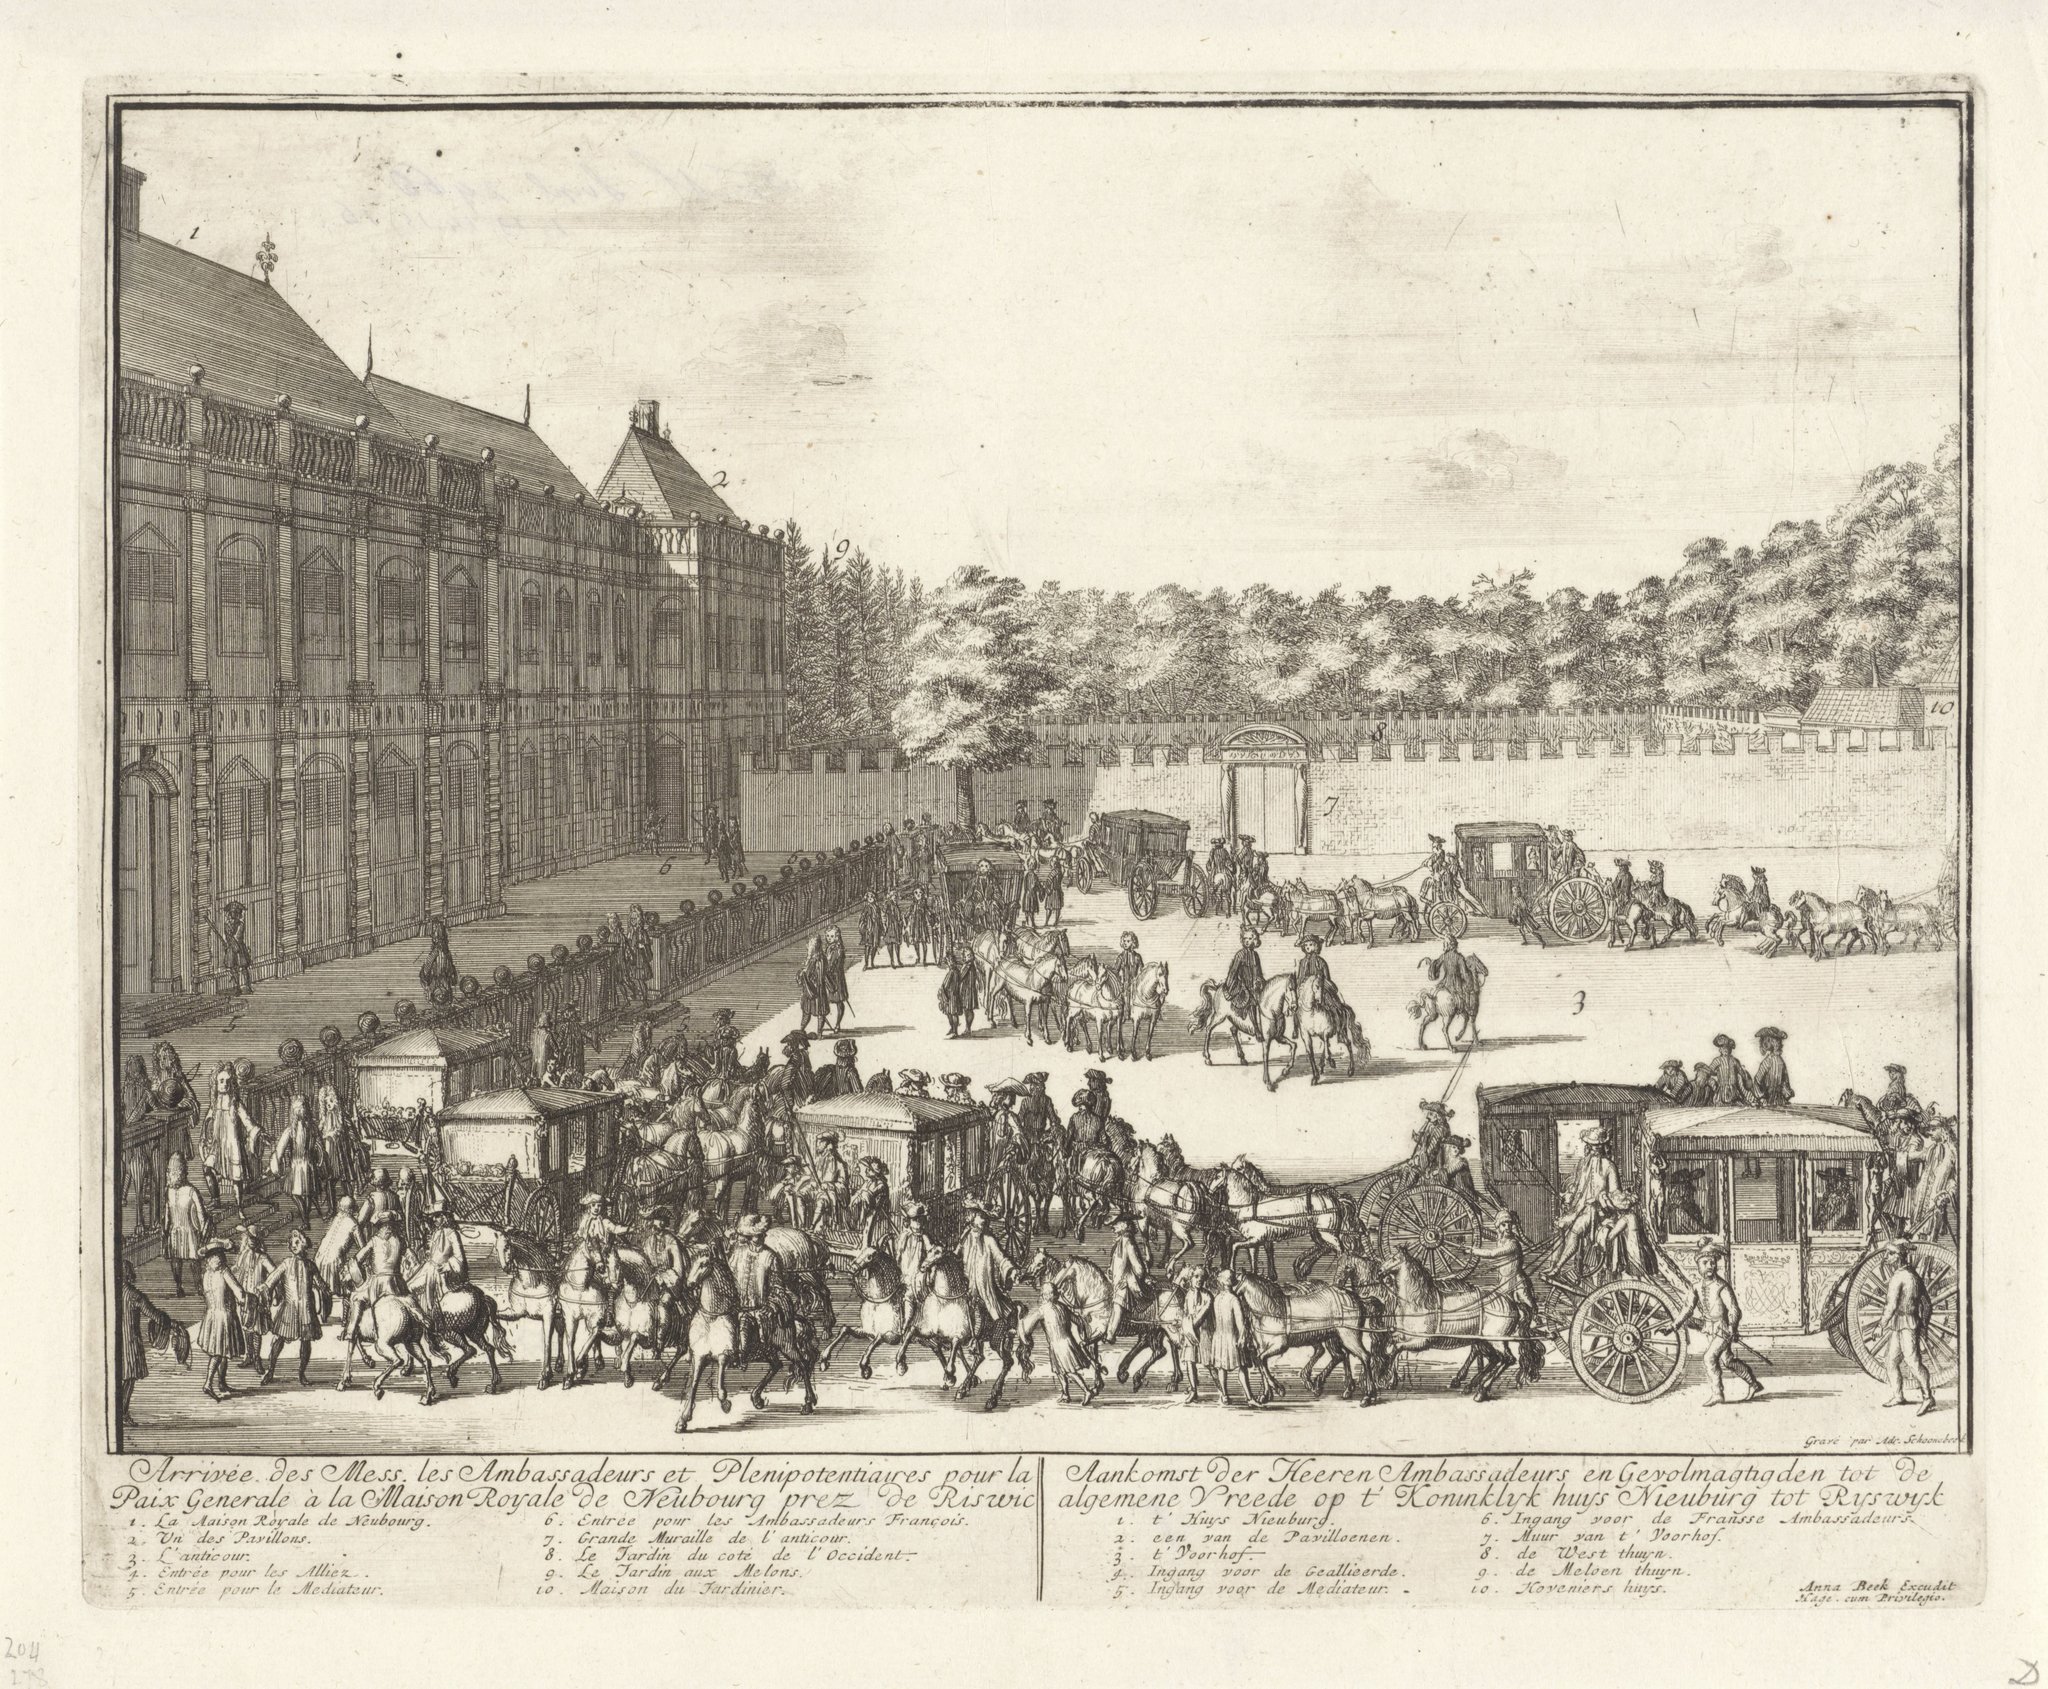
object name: history print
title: Arrival of the Ambassadors at the Royal Palace in Rijswijk, 1697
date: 1697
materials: paper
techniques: etching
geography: the hague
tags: being welcomed ~ travelling, arrival and return ~ travelling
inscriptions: collector's mark: Lugt 2228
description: Aankomst van de koetsen met de ambassadeurs bij het Huis ter Nieuburch te Rijswijk voor de vredesonderhandelingen, 20 mei 1697. In het onderschrift titels en legenda's 1-10 in het Frans en Nederlands. Onderdeel van de serie van vijftien prenten over het Huis ter Nieuburch in Rijswijk en de daar gehouden vredesonderhandelingen resulterend in de Vrede van Rijswijk gesloten op 20 september 1697.